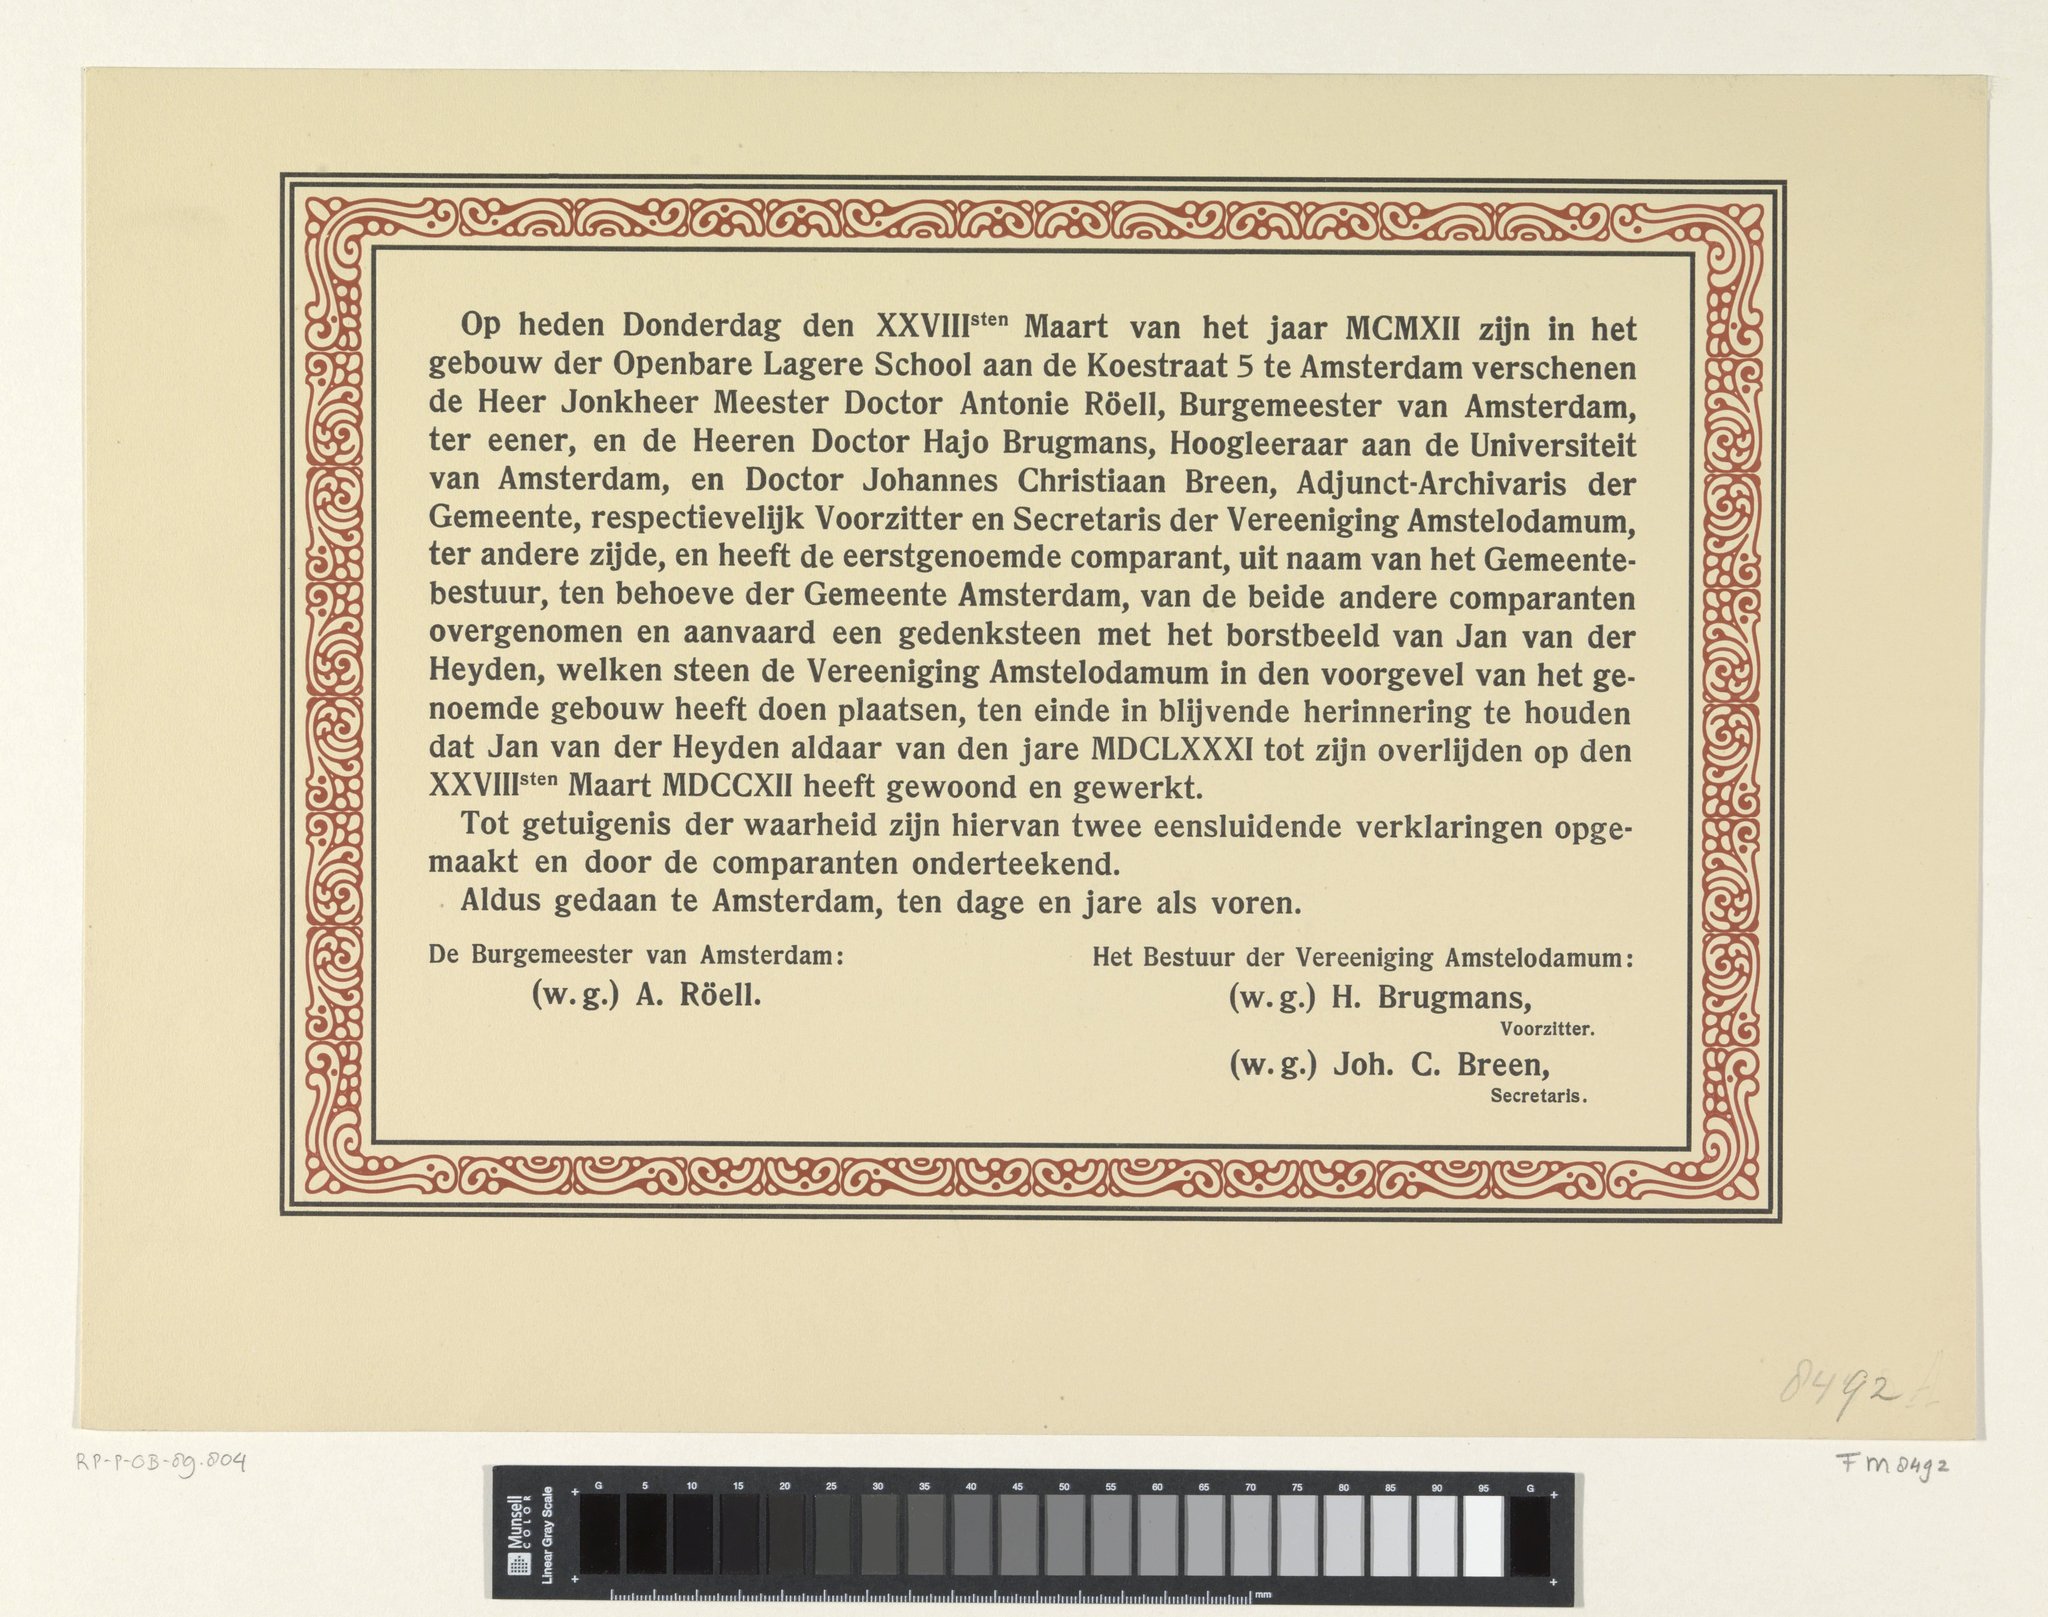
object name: print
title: Verklaring over het plaatsen van een gedenksteen in een gebouw aan de Koestraat te Amsterdam waar Jan van der Heyden gewoond heeft, 1912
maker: Anonymous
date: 1912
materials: paper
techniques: printed materials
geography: netherlands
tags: amsterdam, painter, print maker, draughtsman, jan van der heyden, mayor, antonie röell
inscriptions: collector's mark: Lugt 2228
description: Tekstblad met een verklaring over het plaatsen op 28 maart 1912 namens de Vereniging Amstelodamum van een gedenksteen in het een gebouw van de Openbare Lagere School aan de Koestraat 5 te Amsterdam waar Jan van der Heyden van 1681 tot 1712 gewoond en gewerkt heeft. Namens de burgemeester van Amsterdam A. Röell en het bestuur van de Vereniging Amstelodamum.